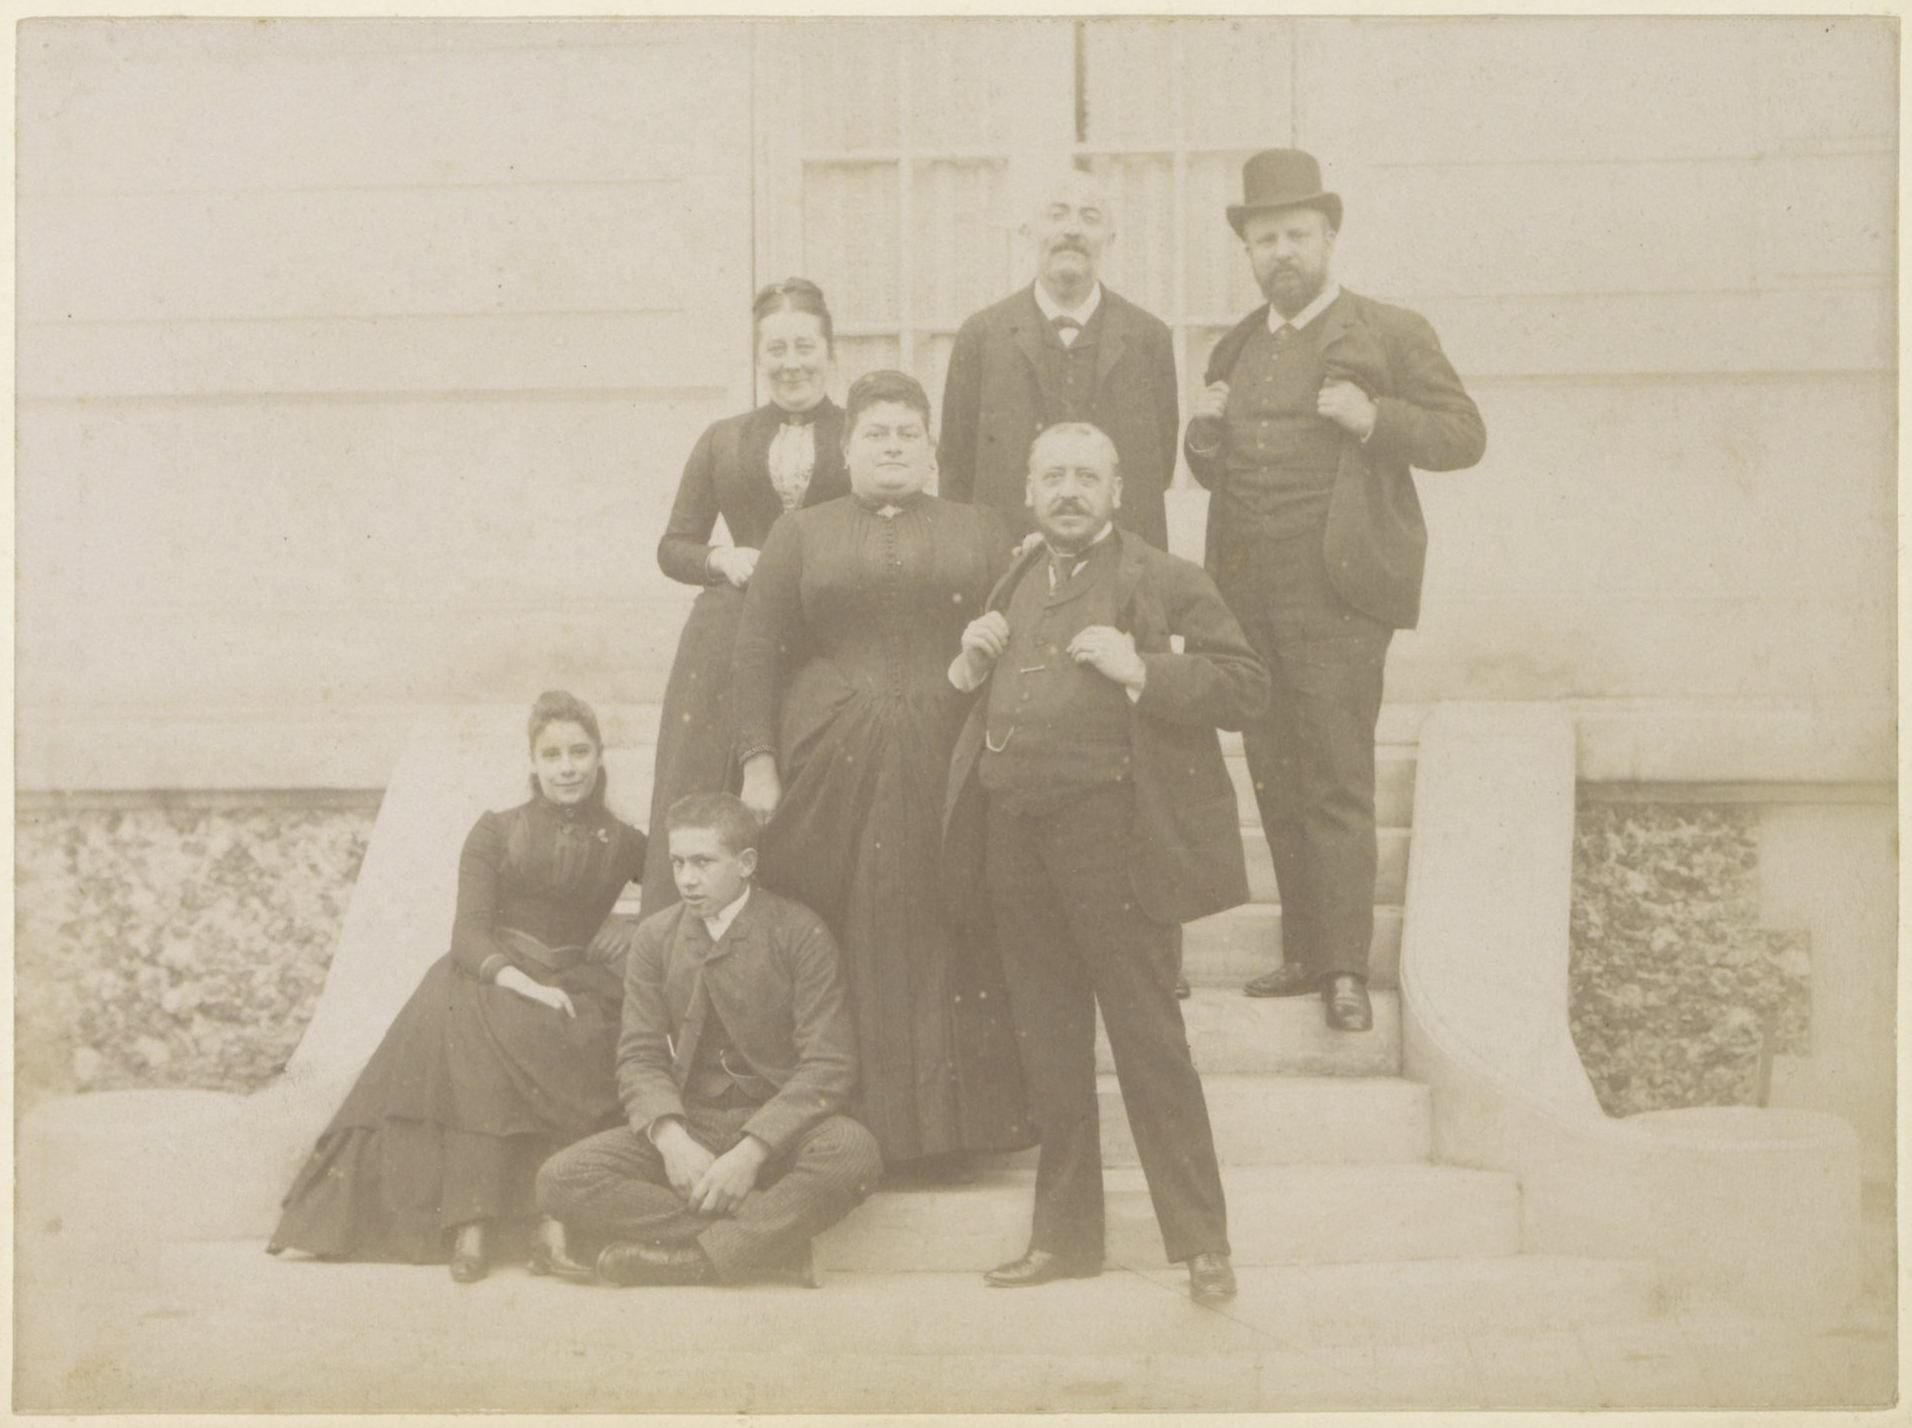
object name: photograph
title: Groepsportret van een Franse familie op de trappen voor een huis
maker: Anonymous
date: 1900-1910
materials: paper, photographic support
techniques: albumen print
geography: france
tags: three generations (family group), france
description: Onderdeel van Fotoalbum van een Franse amateurfotograaf met opnames van een familie, distilleerderij Delizy & Doistau Fils, het leger en bezienswaardigheden in Frankrijk.